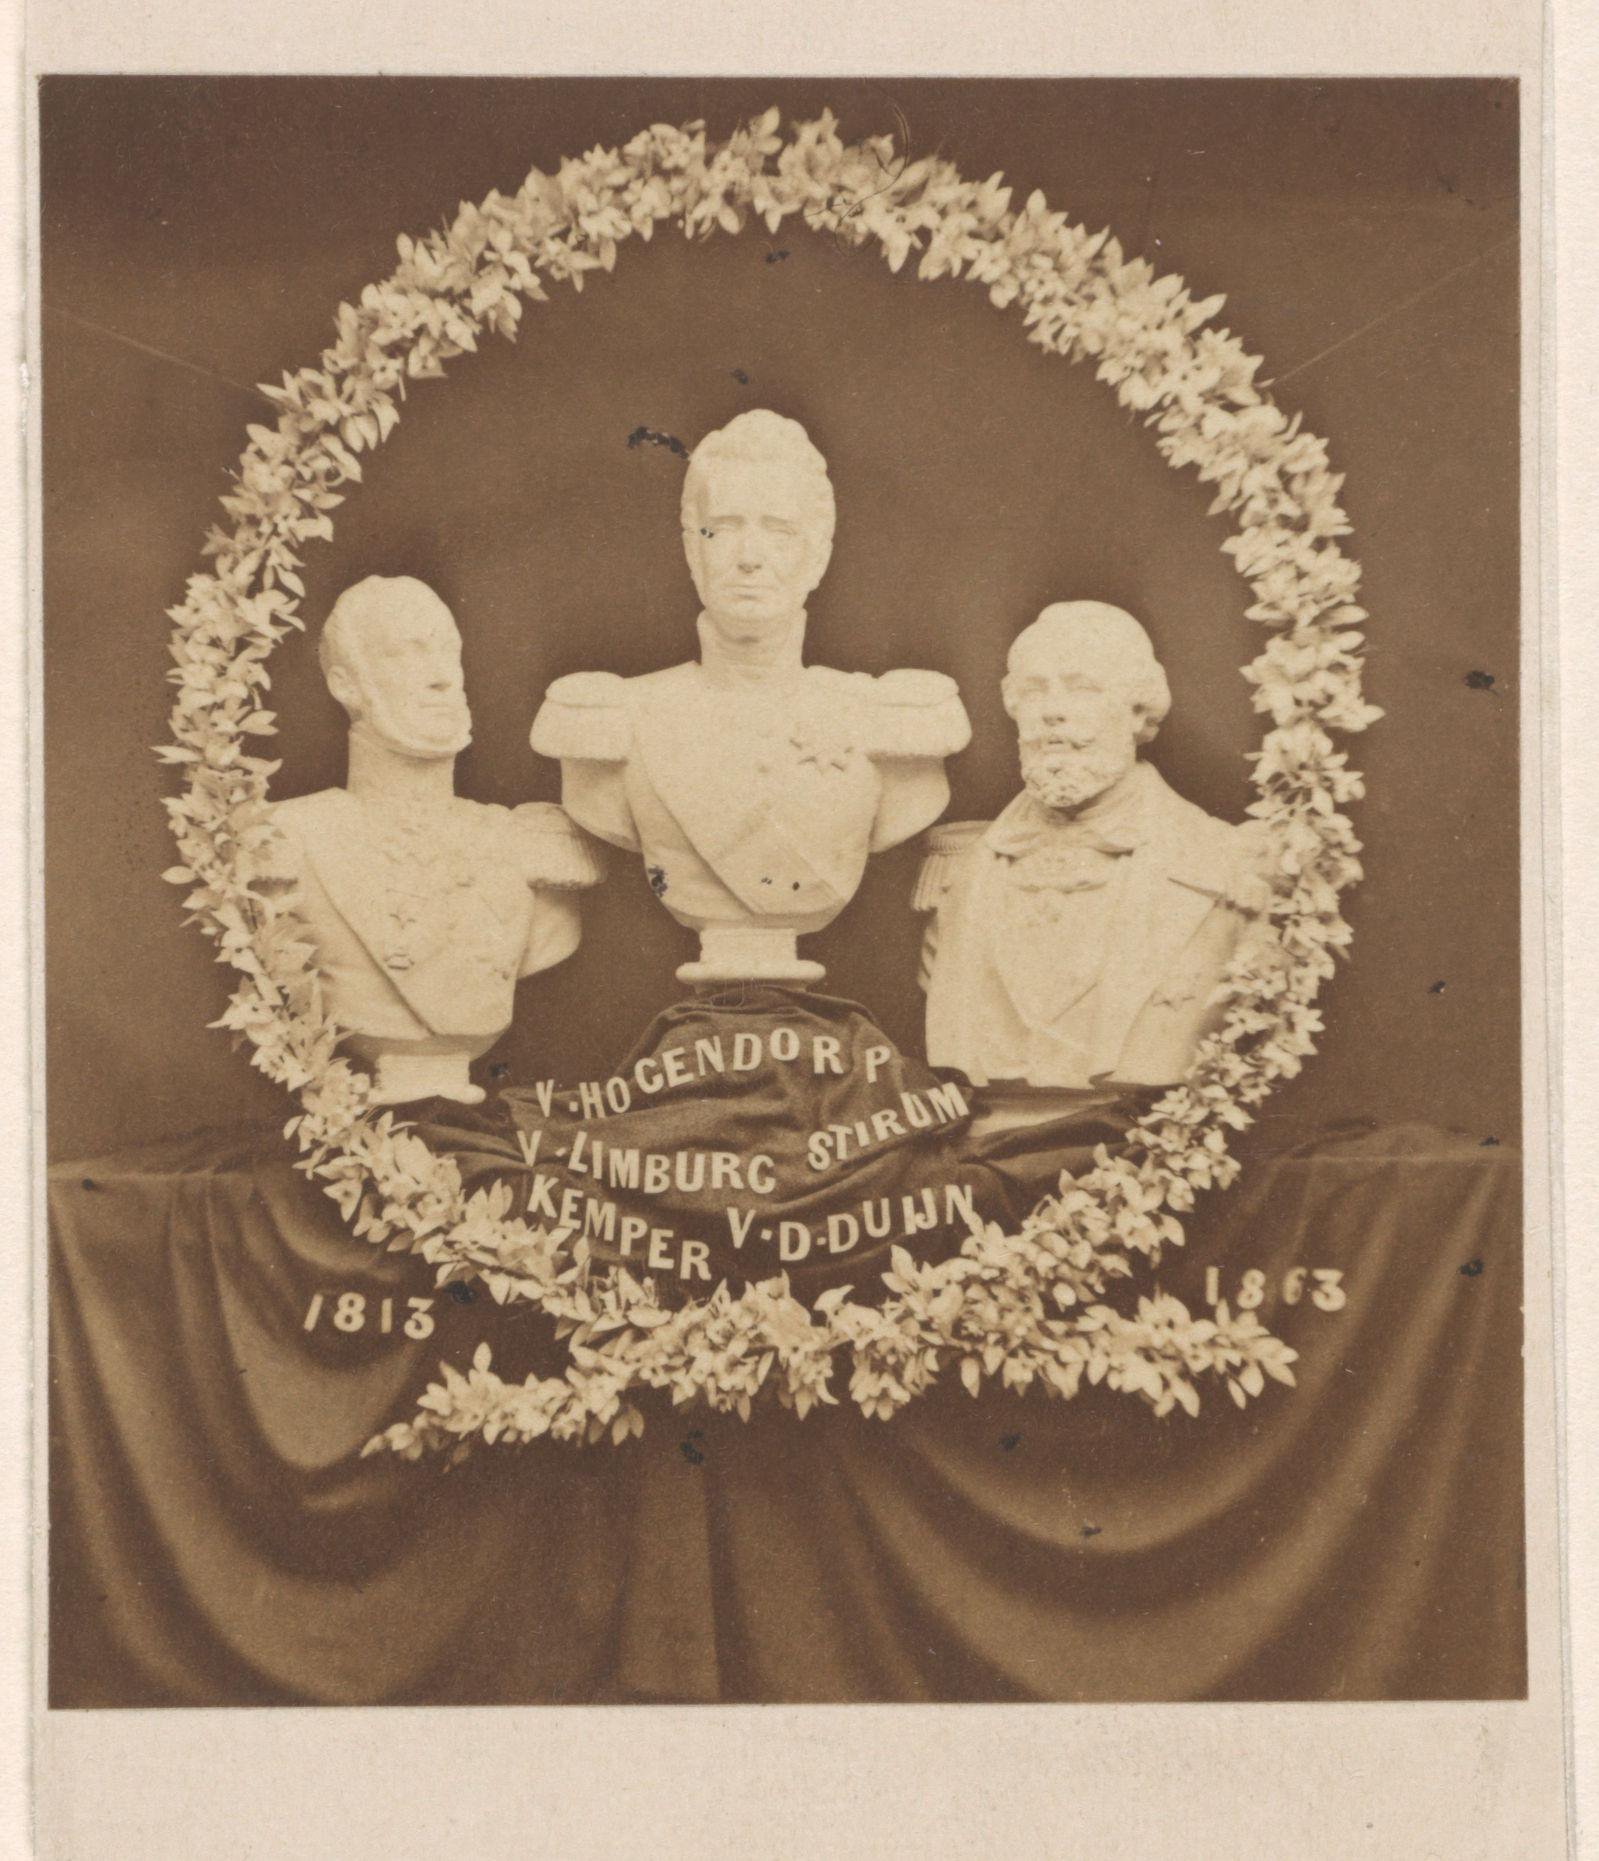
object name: photograph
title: Bustes van Gijsbert Karel, graaf van Hogendorp, Leopold, graaf van Limburg Stirum, en Adam François Jules Armand van der Duyn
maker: Anonymous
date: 1863-1930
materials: photographic support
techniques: photography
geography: netherlands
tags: the hague, gijsbert karel graaf van hogendorp, adam françois jules armand van der duyn, piece of sculpture, reproduction of a piece of sculpture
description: De hier vermelde titel verwijst naar de hoogst verkregen titel van de geportretteerde, niet per se naar de titel die de geportretteerde op deze voorstelling draagt.